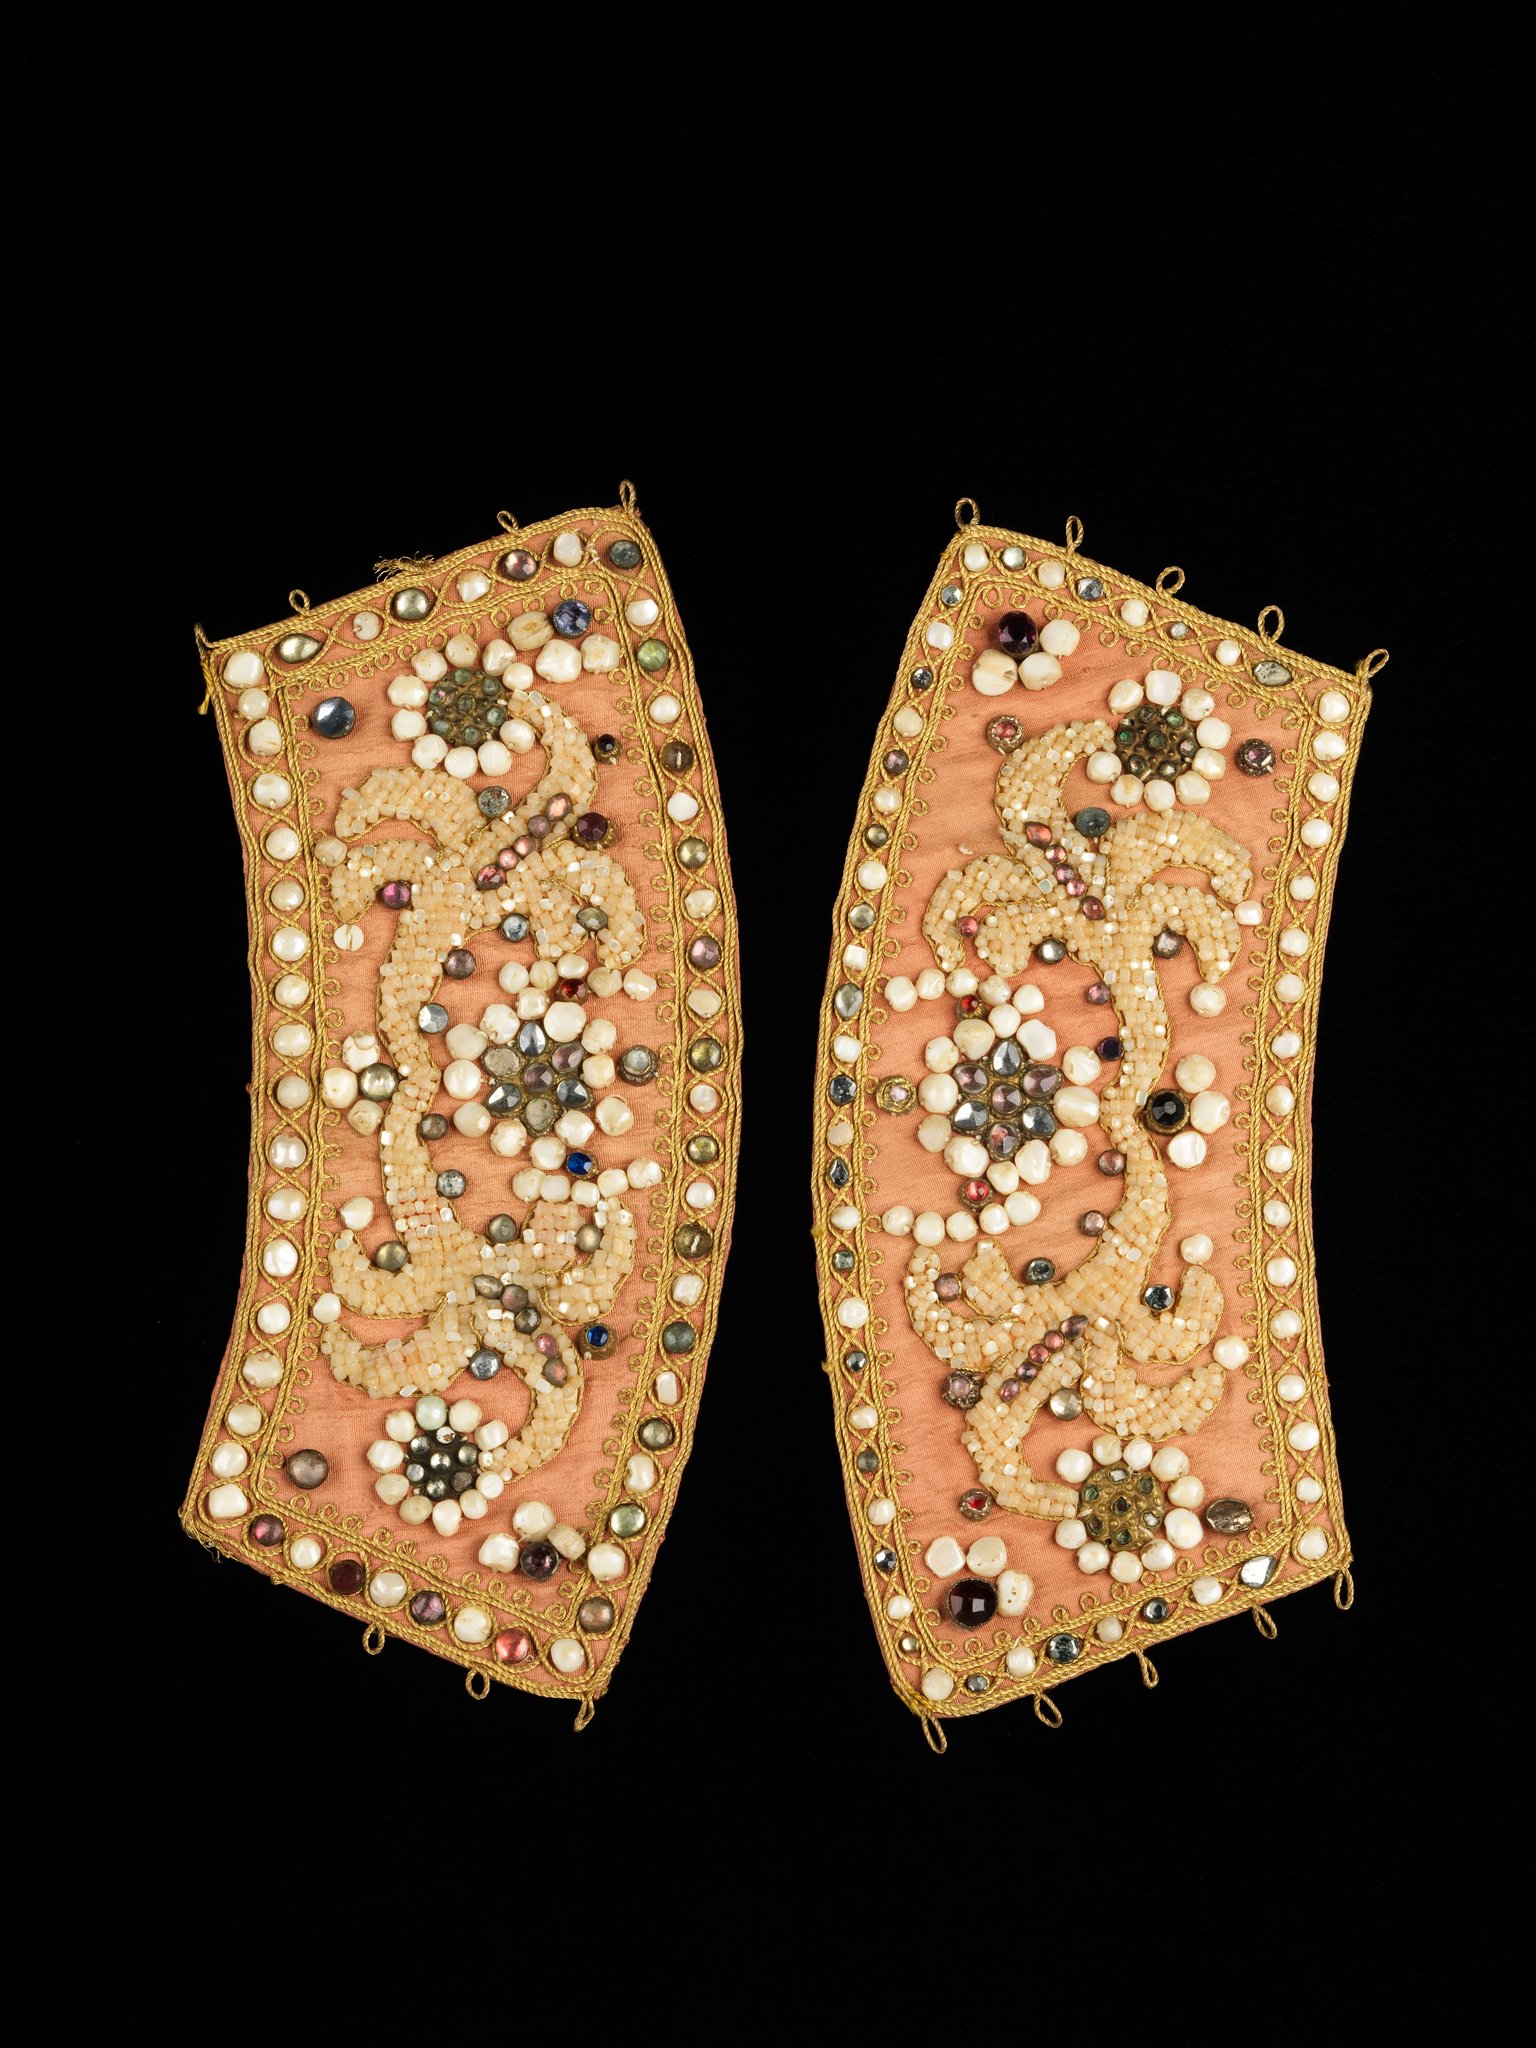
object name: cuff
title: Cuffs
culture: russian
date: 1776-1800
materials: glass, metal, mother of pearl, pearl, silk, stone